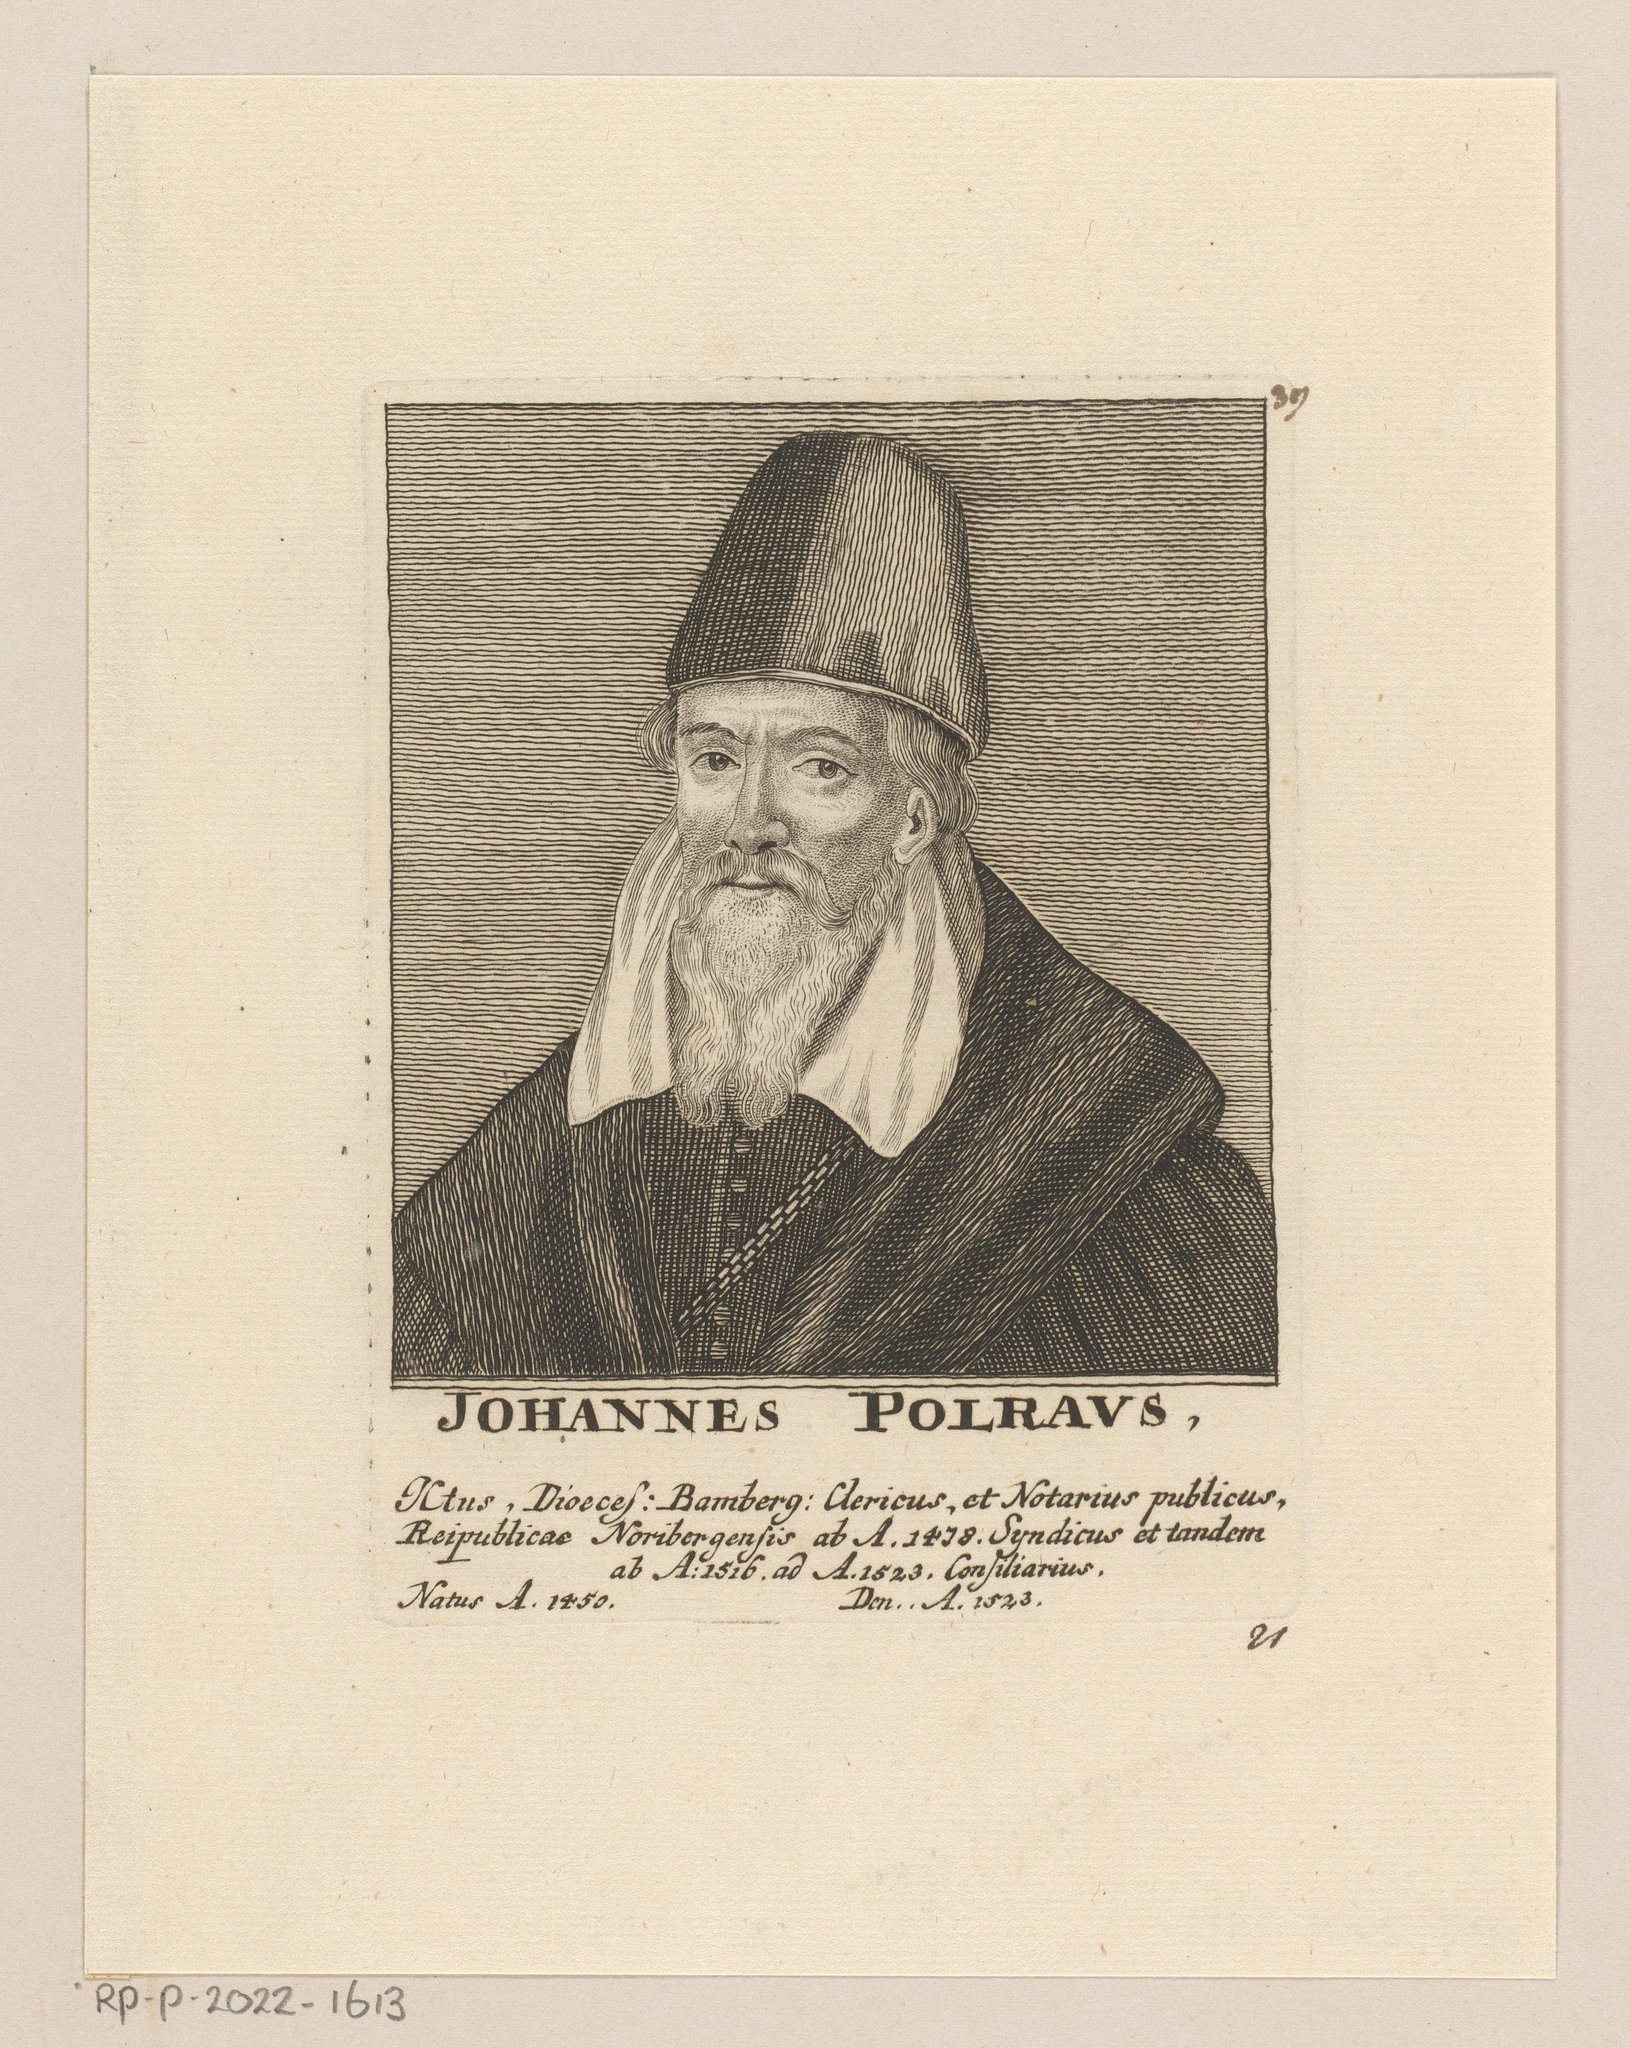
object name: print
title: Portret Johannes Polraus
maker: Anonymous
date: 1725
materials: paper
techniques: engraving, etching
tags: historical persons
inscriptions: number: ‘39’, number: ‘21’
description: Prent waarschijnlijk uit: Rothscholtz, Friedrich. Icones virorum omnium ordinum eruditione: omnique item genere et varietate artium de republica litteraria et speciatim de Academiis et Gymnasiis (...). Neurenberg: erven Johann Daniel Tauber, 1725, dl. 1 of 2.